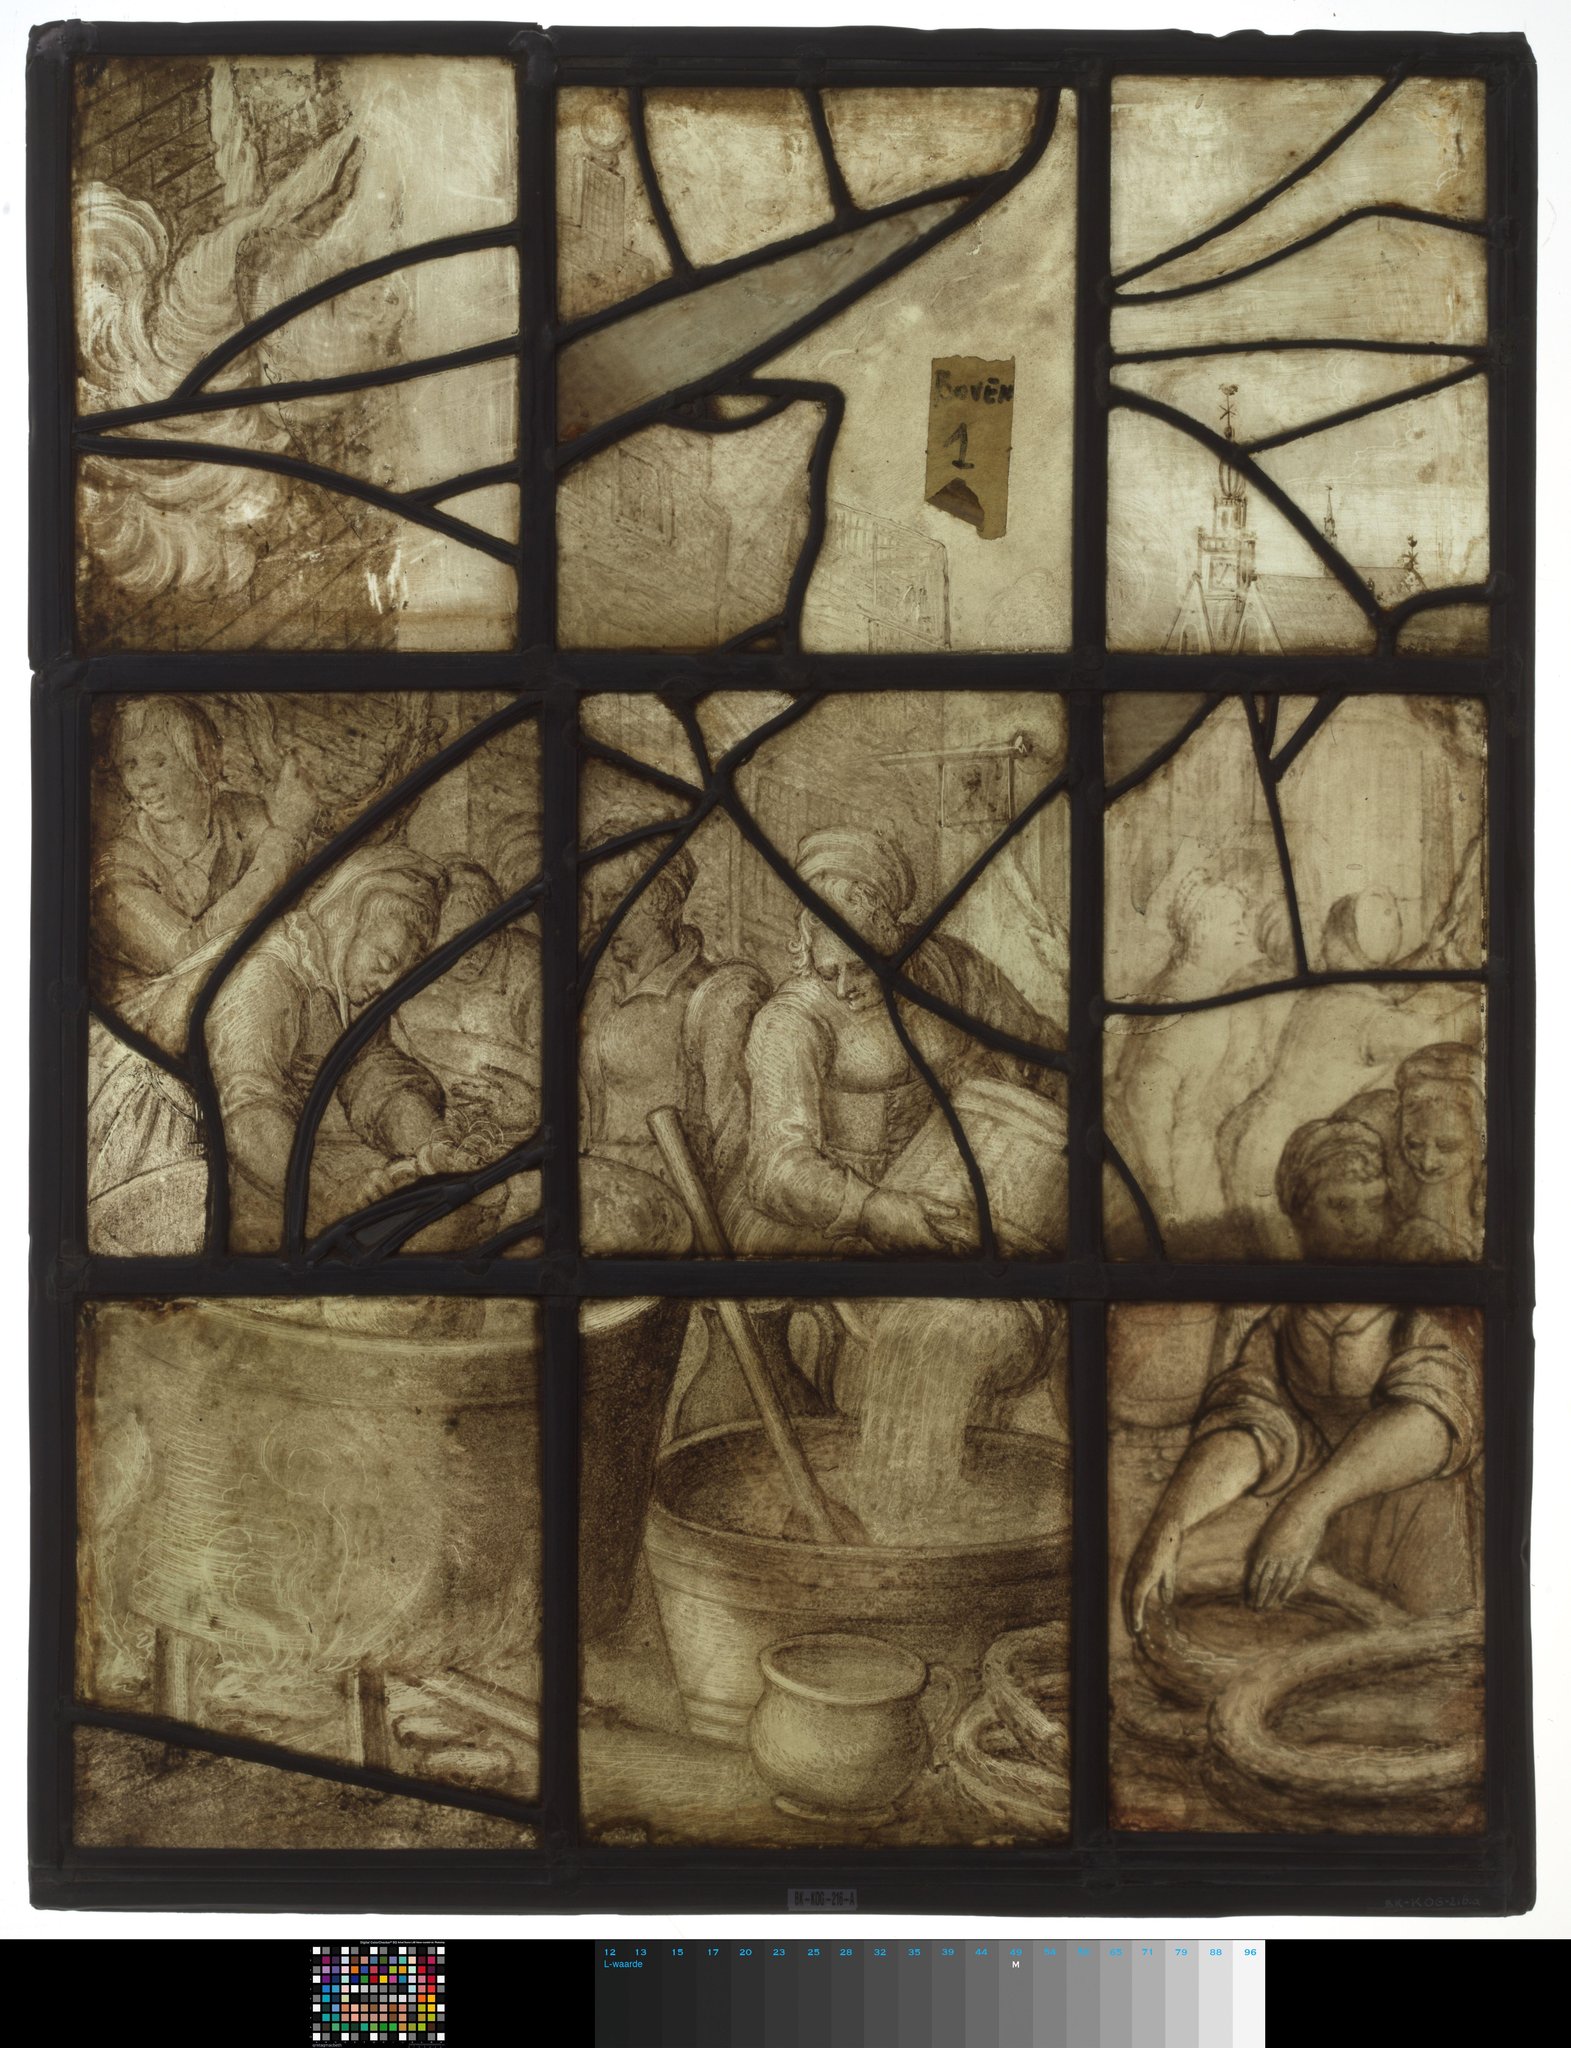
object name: light window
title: Ruit met het wapen van Alkmaar met onderschrift "Alkmaria Victrix 1573"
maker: Anonymous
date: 1573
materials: glass, lead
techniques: leading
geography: netherlands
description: Ruit, glas-in-lood, bestaande uit zestien afzonderlijke panelen die tezamen het wapen van Alkmaar laten zien. Onderschrift: ALKMARIA VICTRIX. Gedateerd 1573.